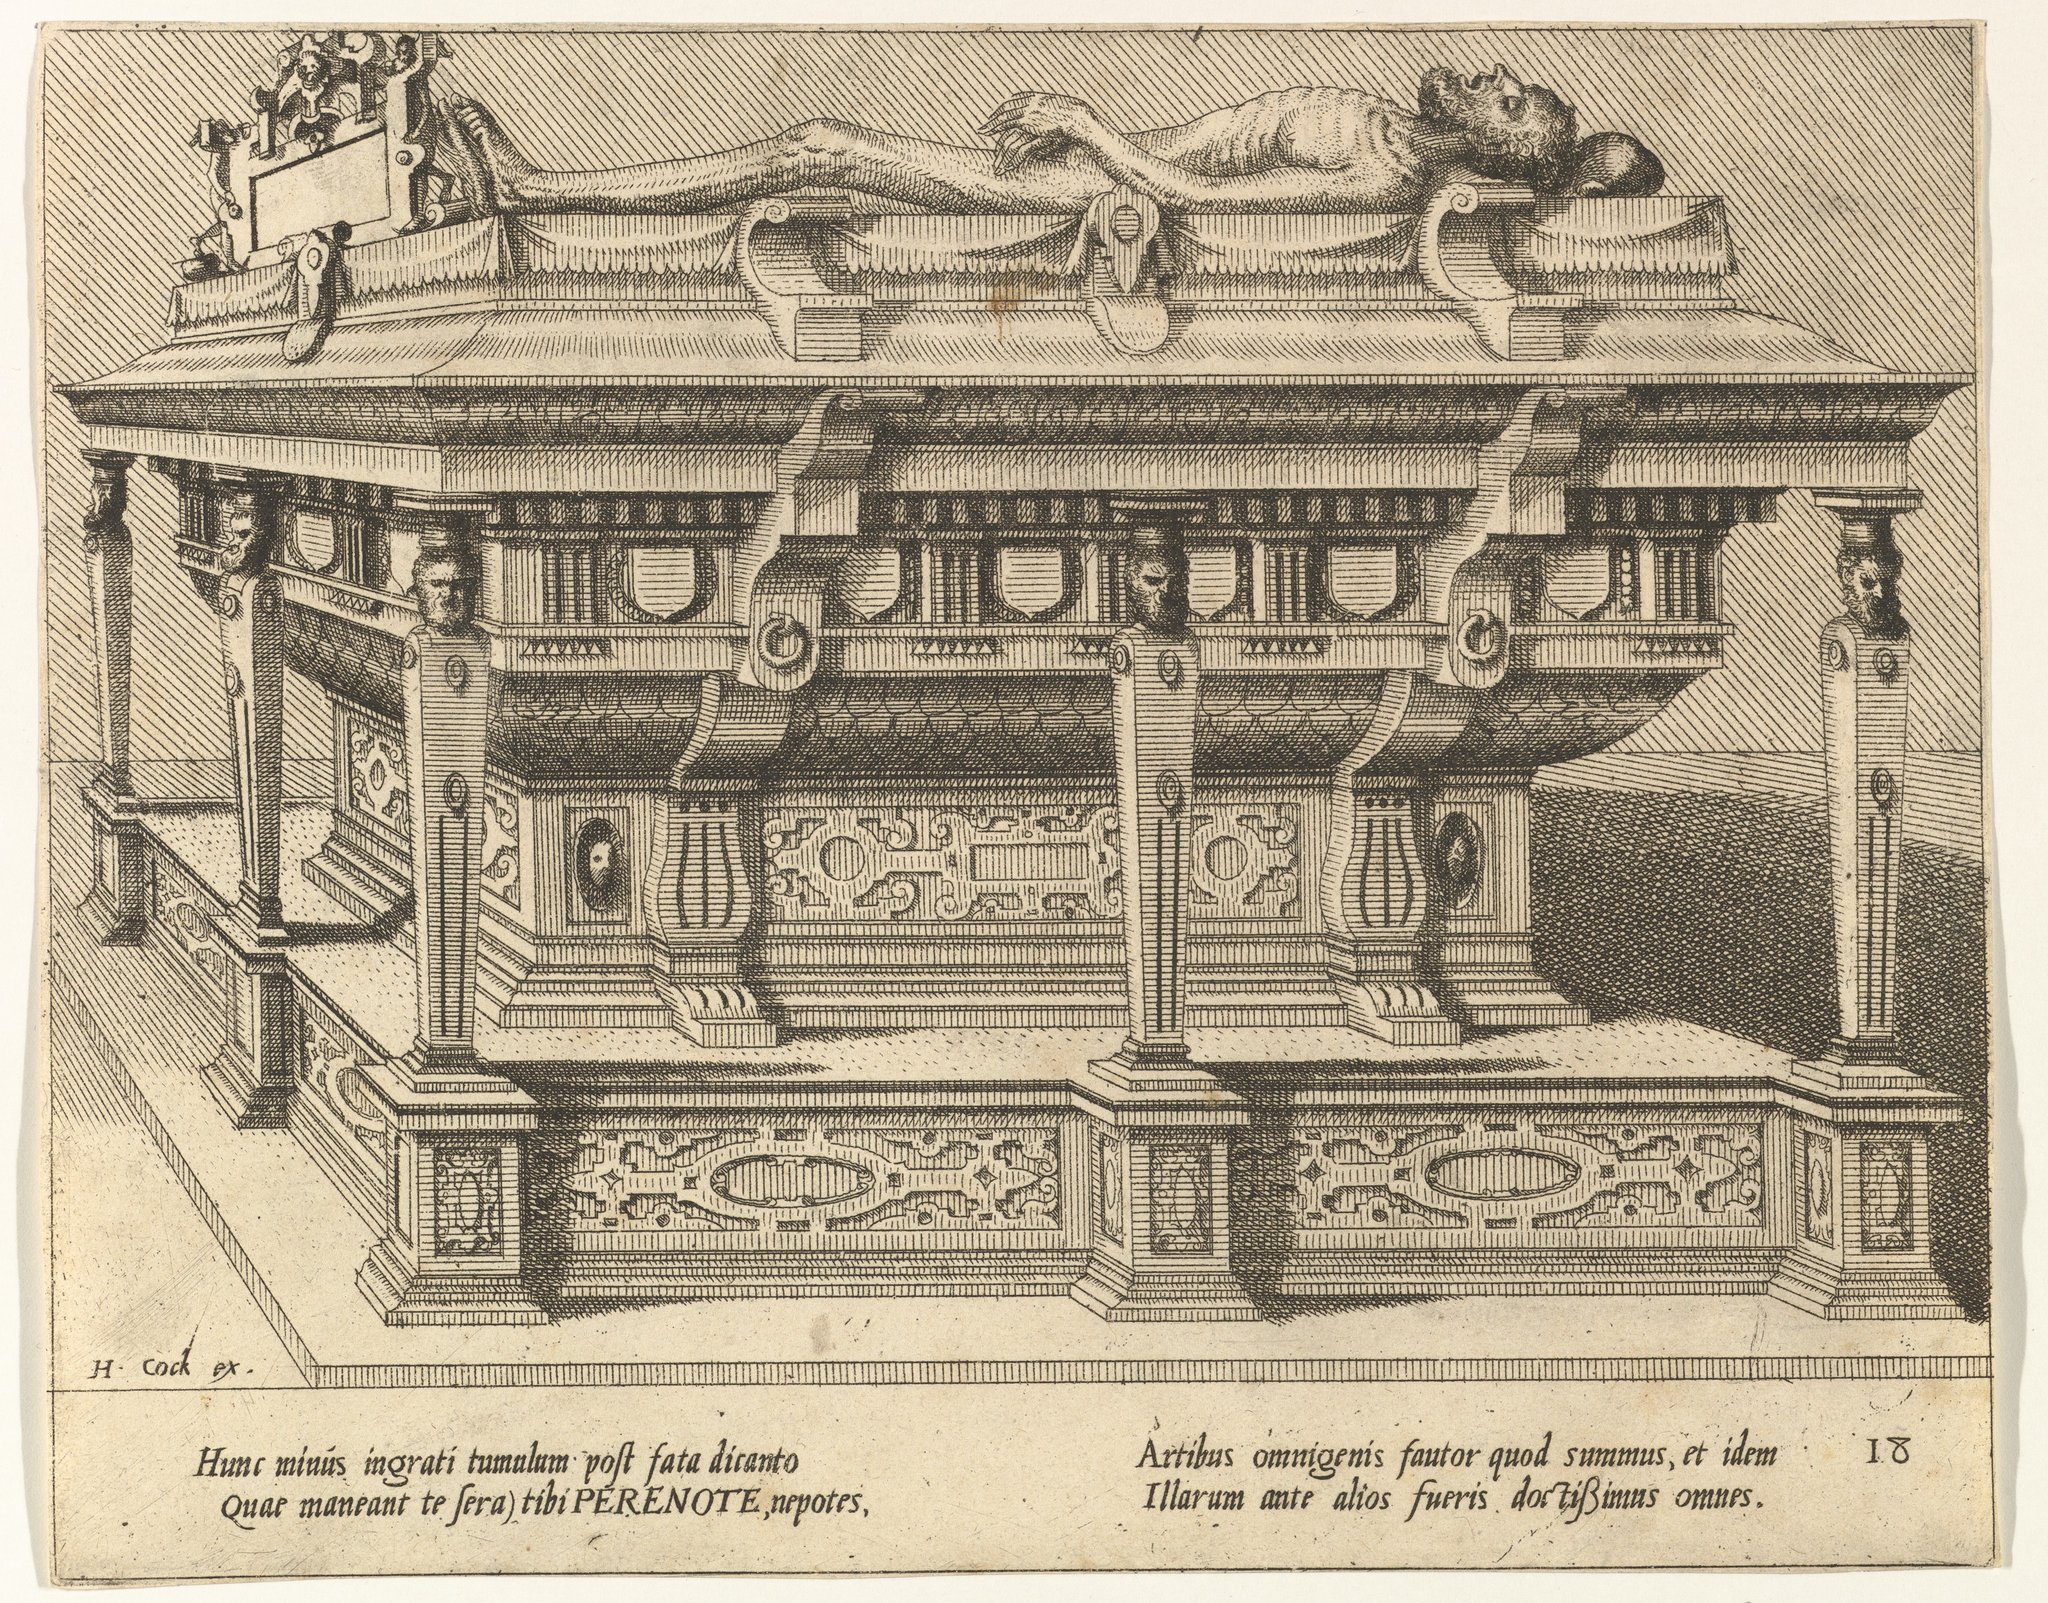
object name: collection ornament architecture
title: Cœnotaphiorum (18)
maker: hans vredeman de vries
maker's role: artist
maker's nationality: netherlandish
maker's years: 1527-1606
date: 1563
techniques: etching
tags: architecture,corpses